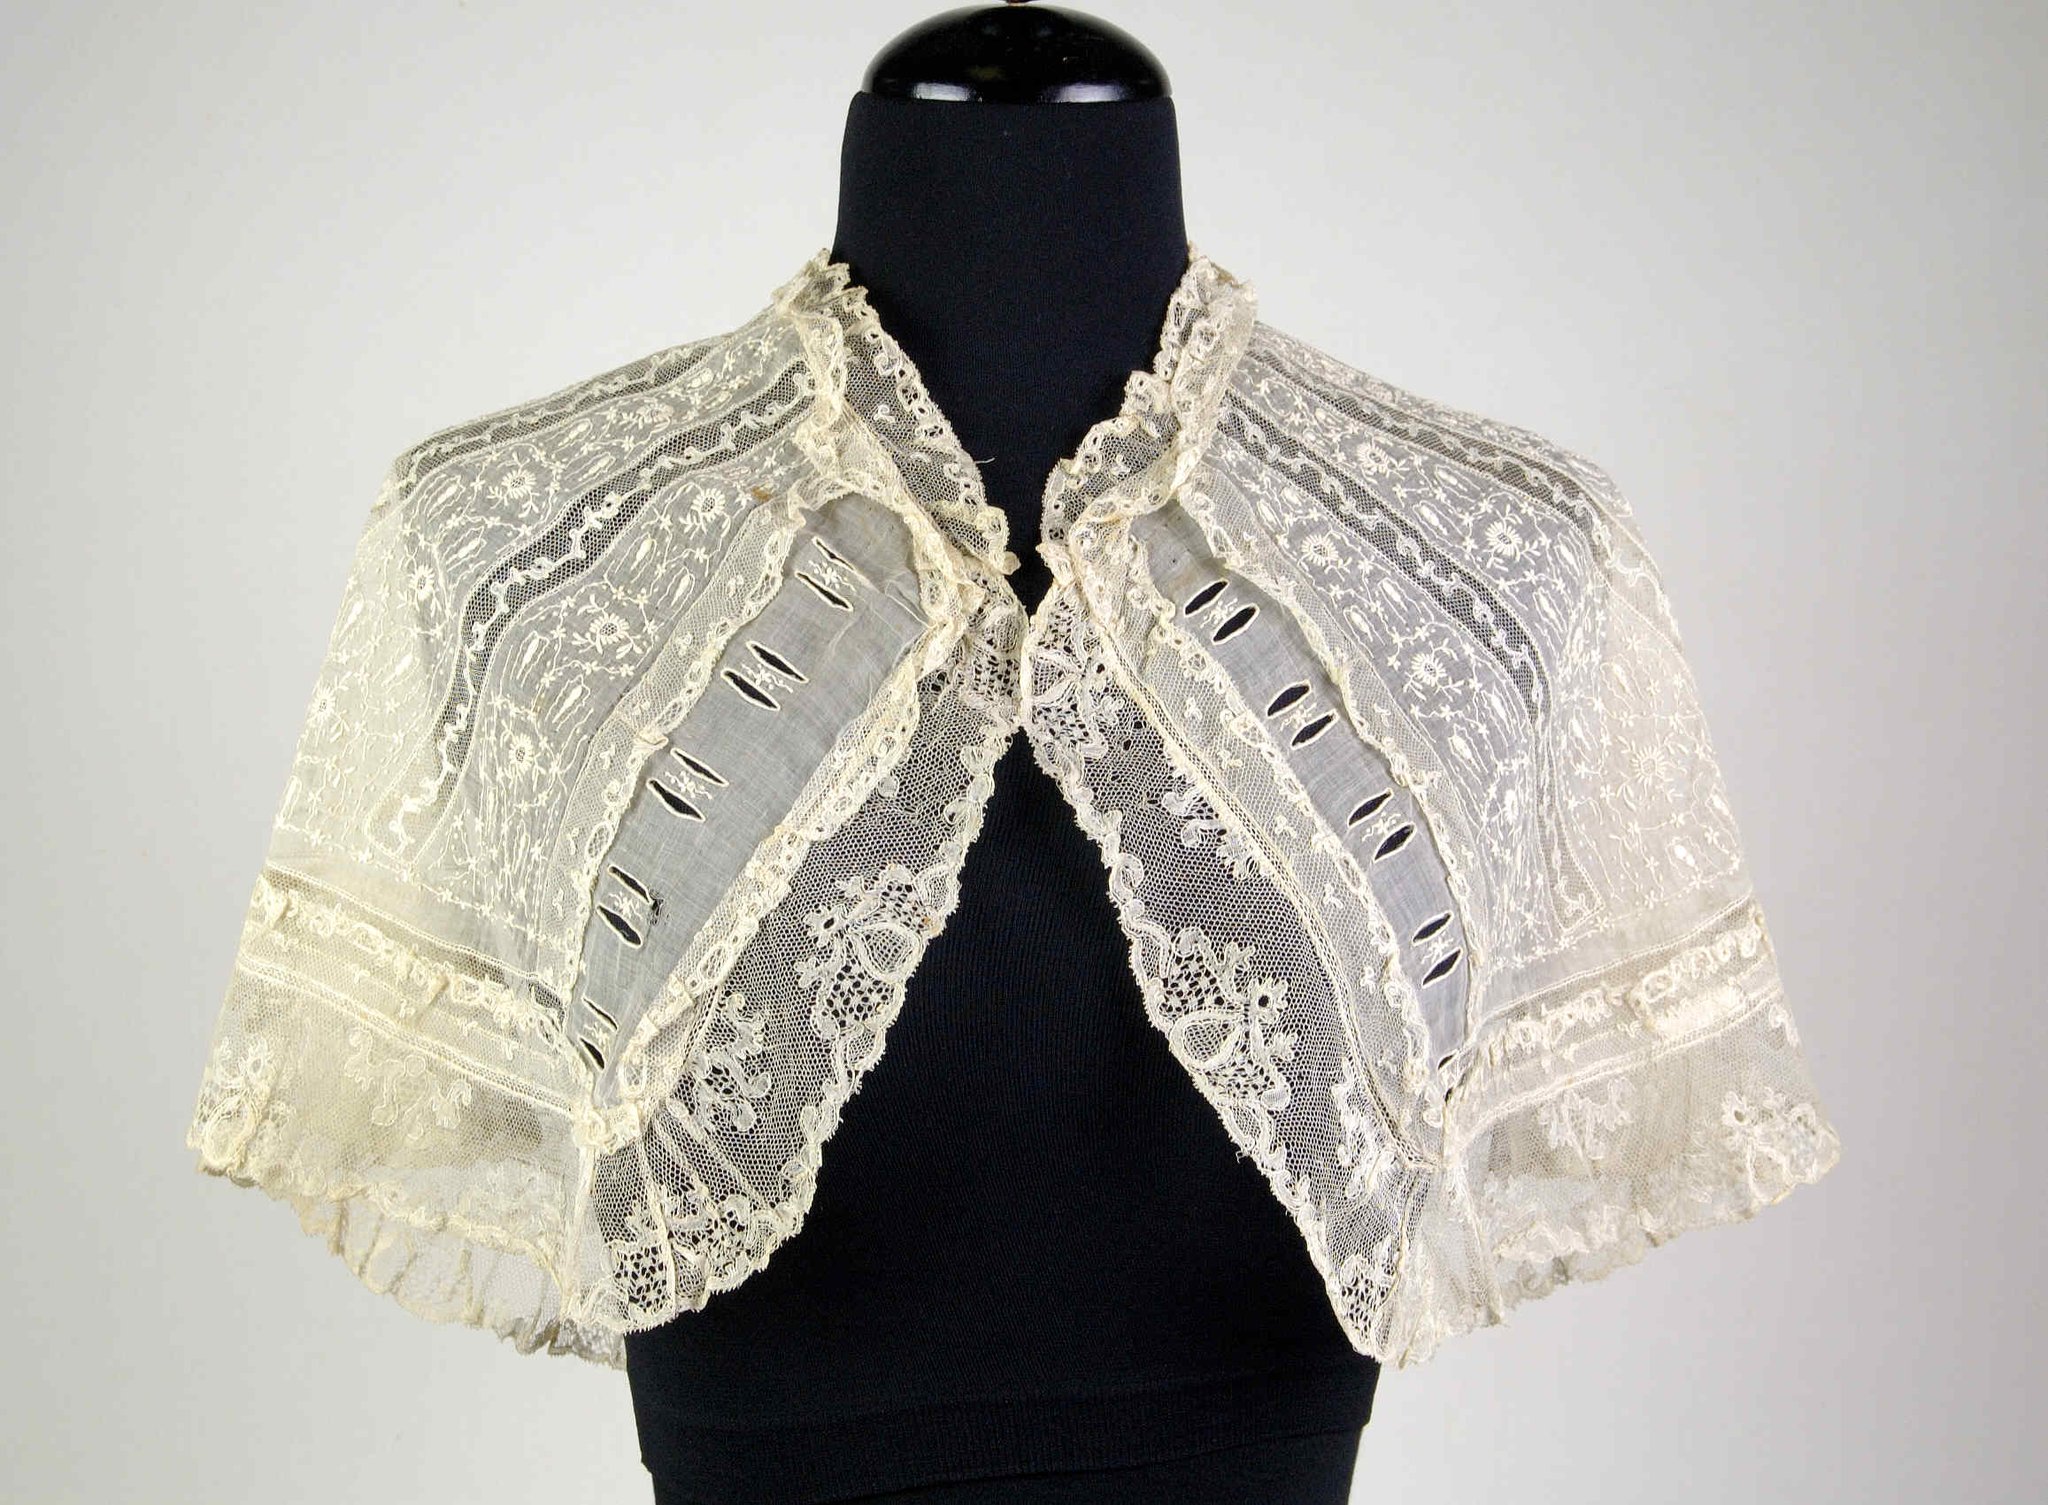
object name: collar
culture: american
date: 1880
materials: cotton